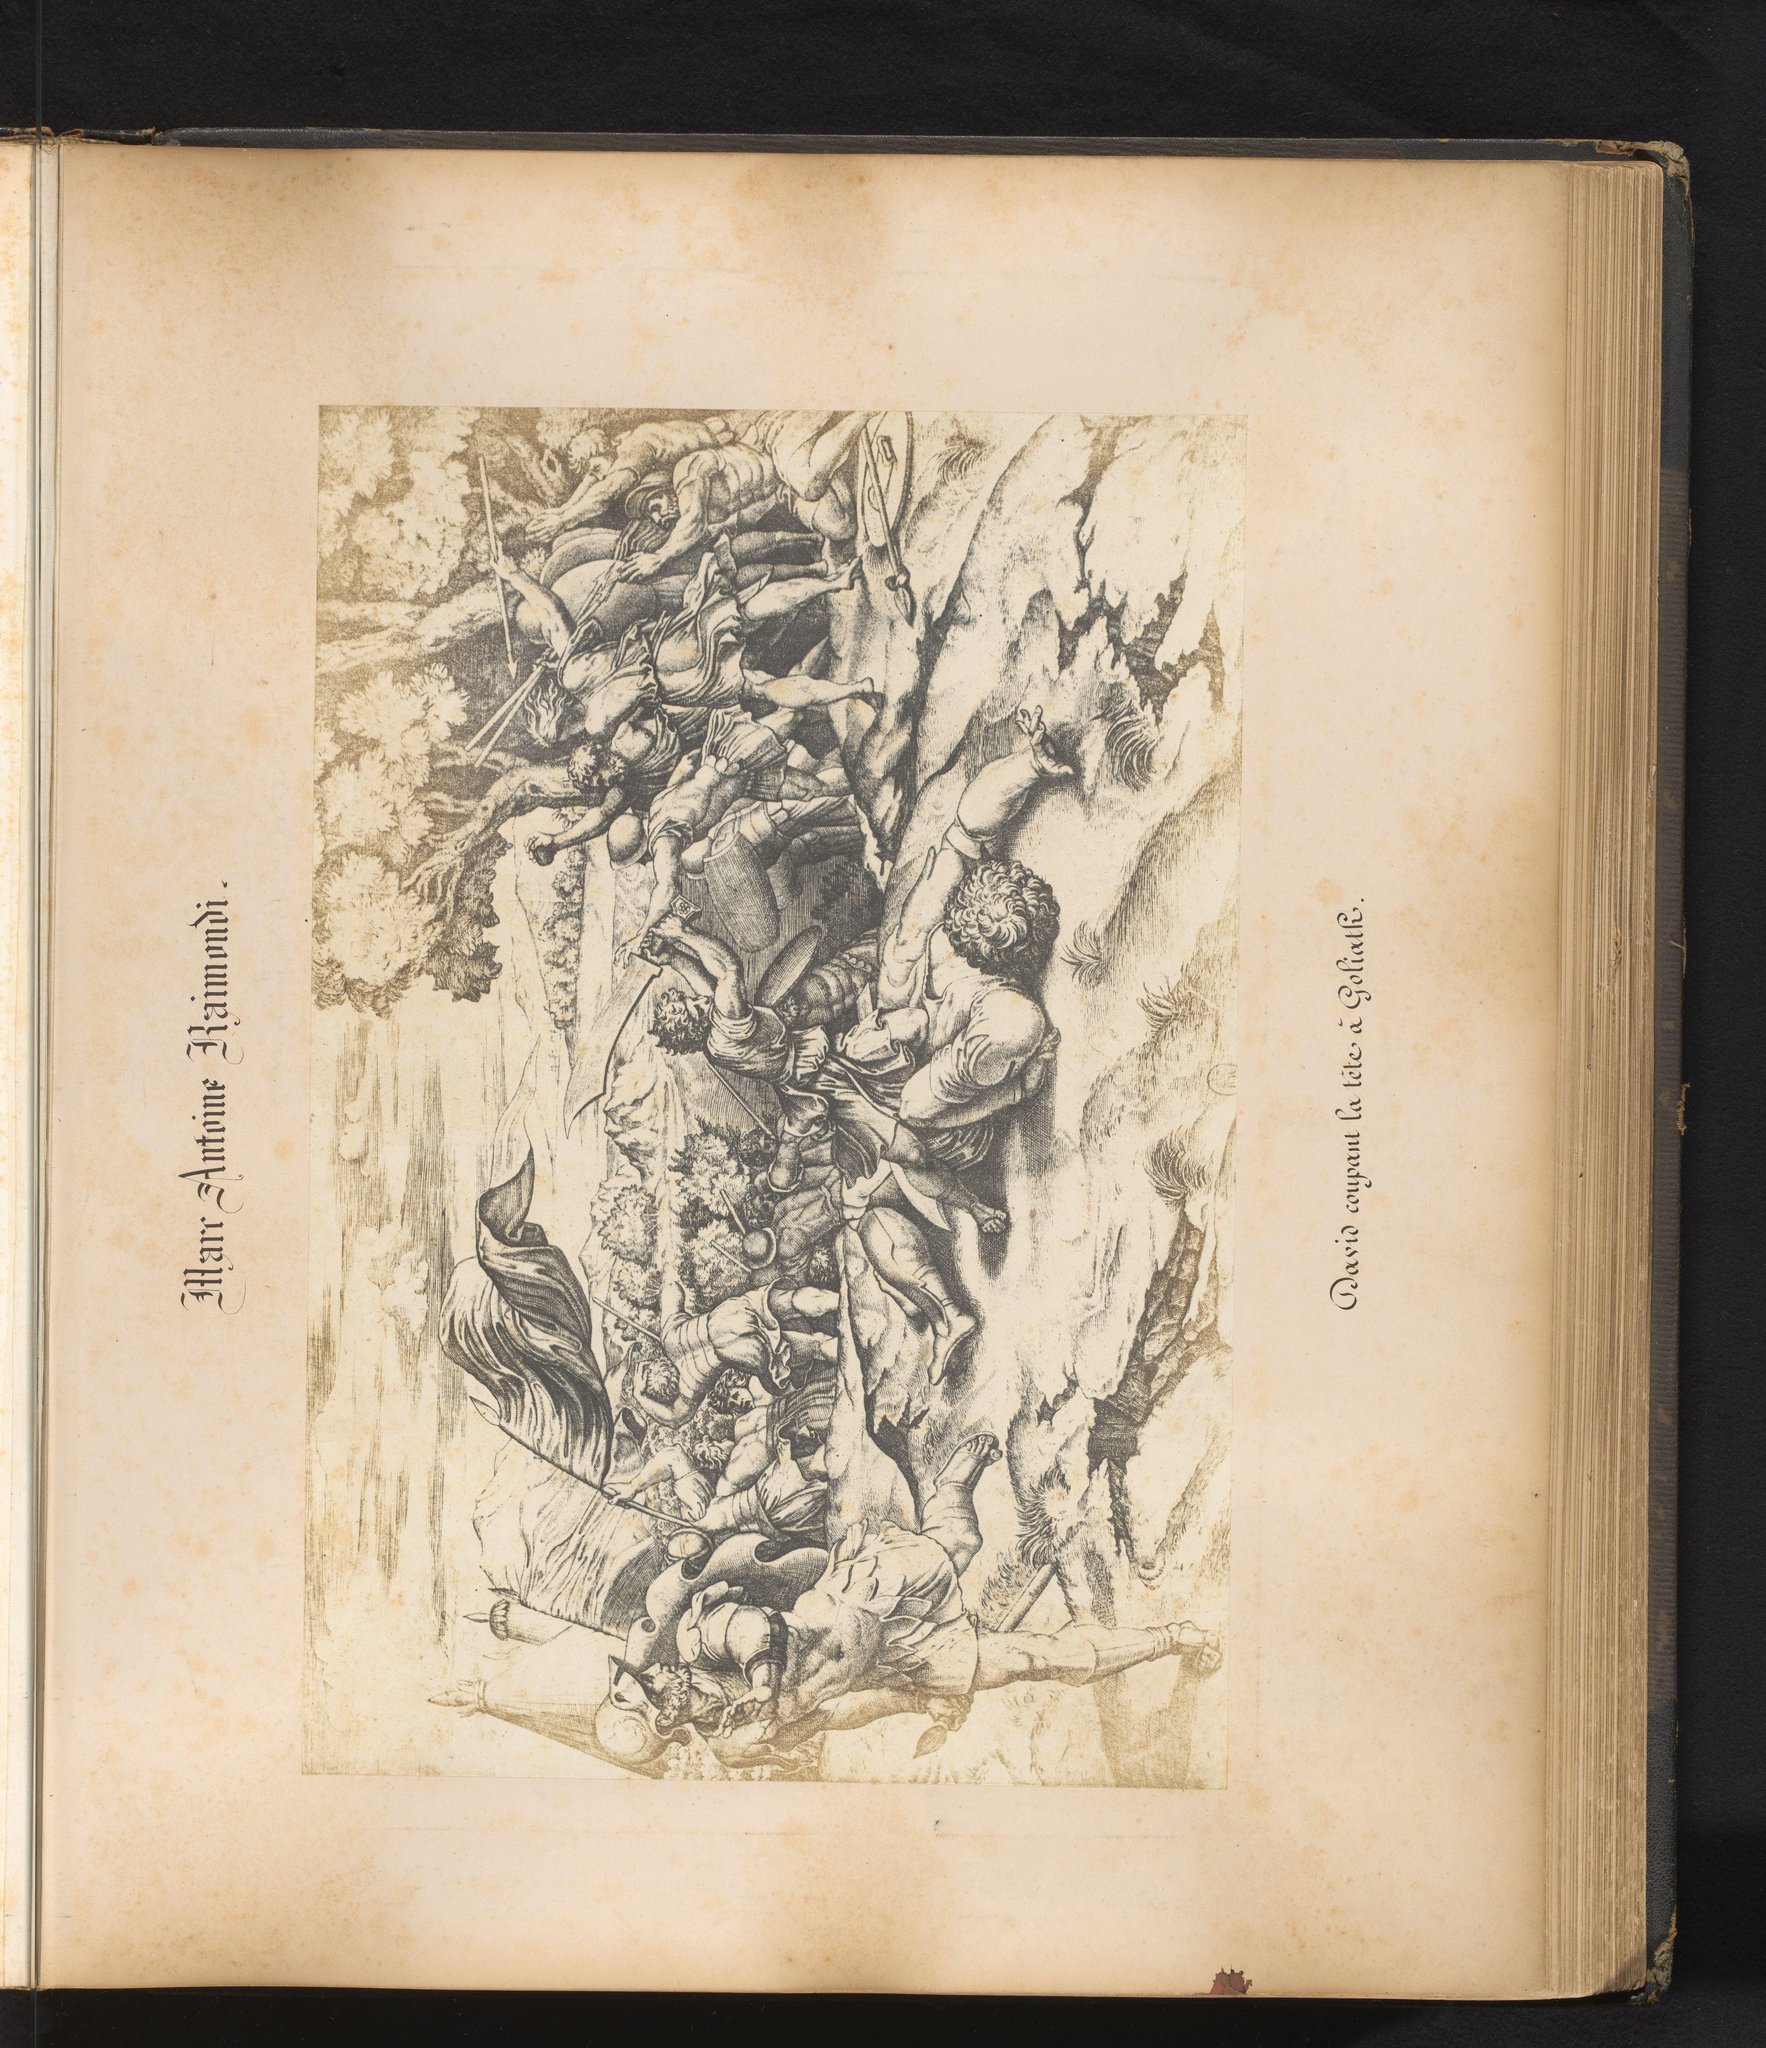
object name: photograph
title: Fotoreproductie van een gravure van David die het hoofd van Goliat afhakt door Marcantonio Raimondi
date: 1848-1853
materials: photographic support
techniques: salted paper print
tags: david beheads goliath with a sword